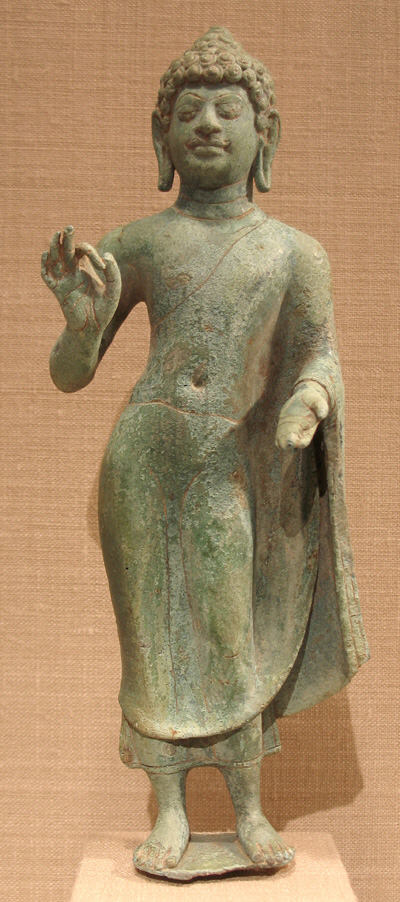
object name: figure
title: Standing Buddha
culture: thai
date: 701-800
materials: bronze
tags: buddhism,buddha